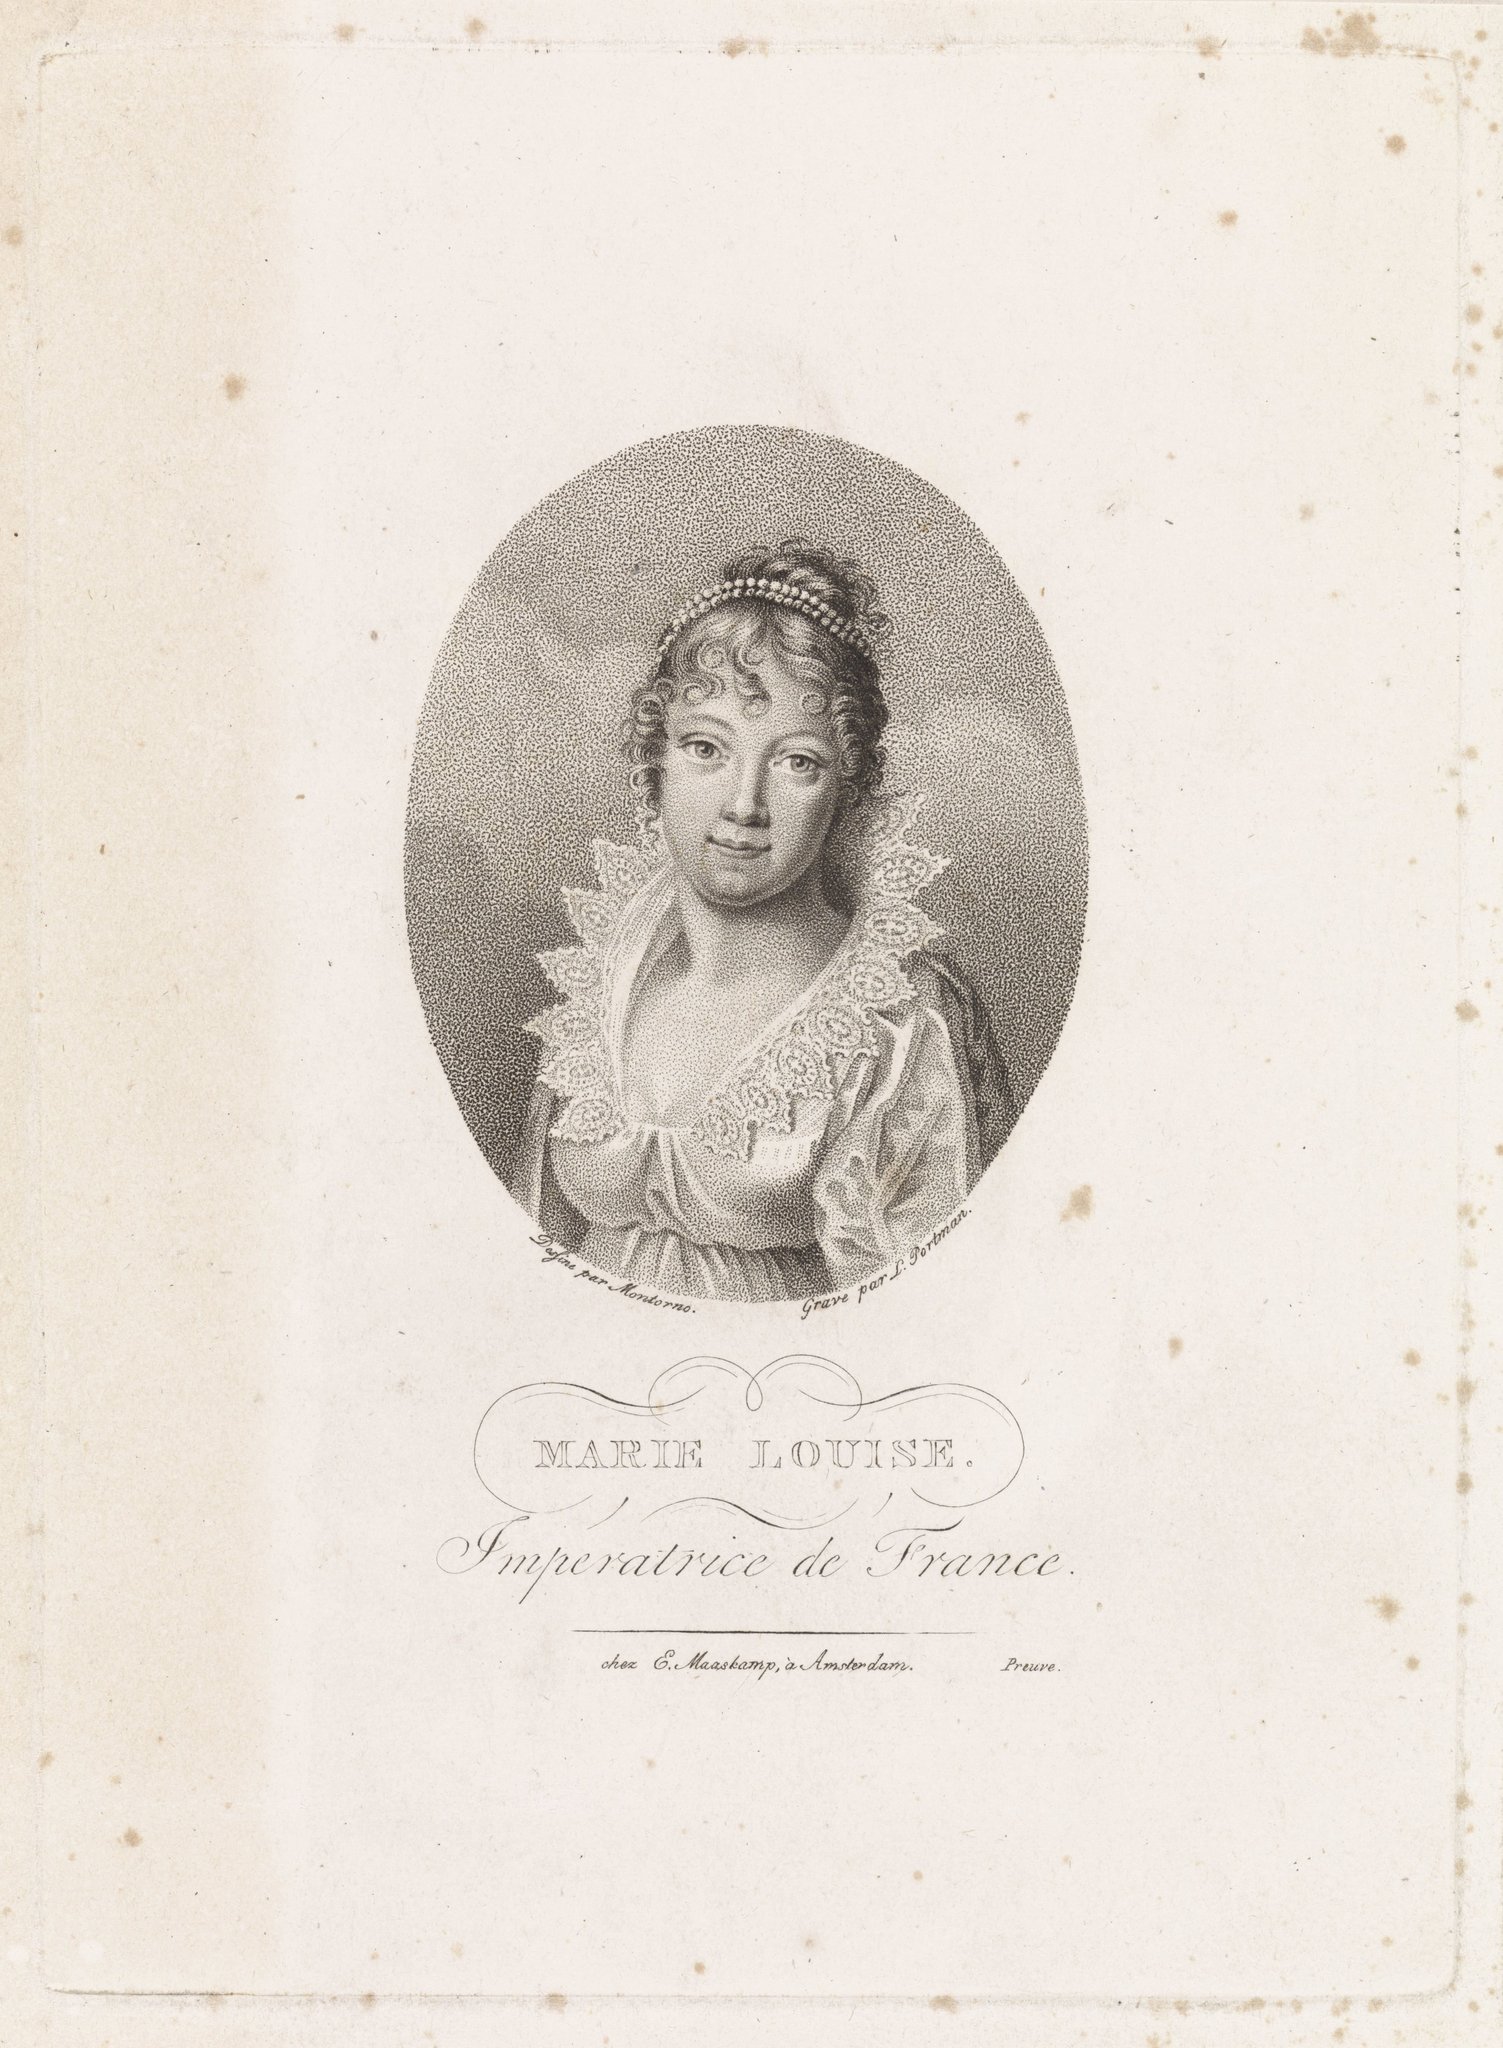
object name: print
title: Portret van Marie Louise van Oostenrijk, keizerin van Frankrijk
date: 1794-1828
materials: paper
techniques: stippled etching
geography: amsterdam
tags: vienna, marie louise van oostenrijk (keizerin der fransen)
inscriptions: collector's mark: Lugt 2228